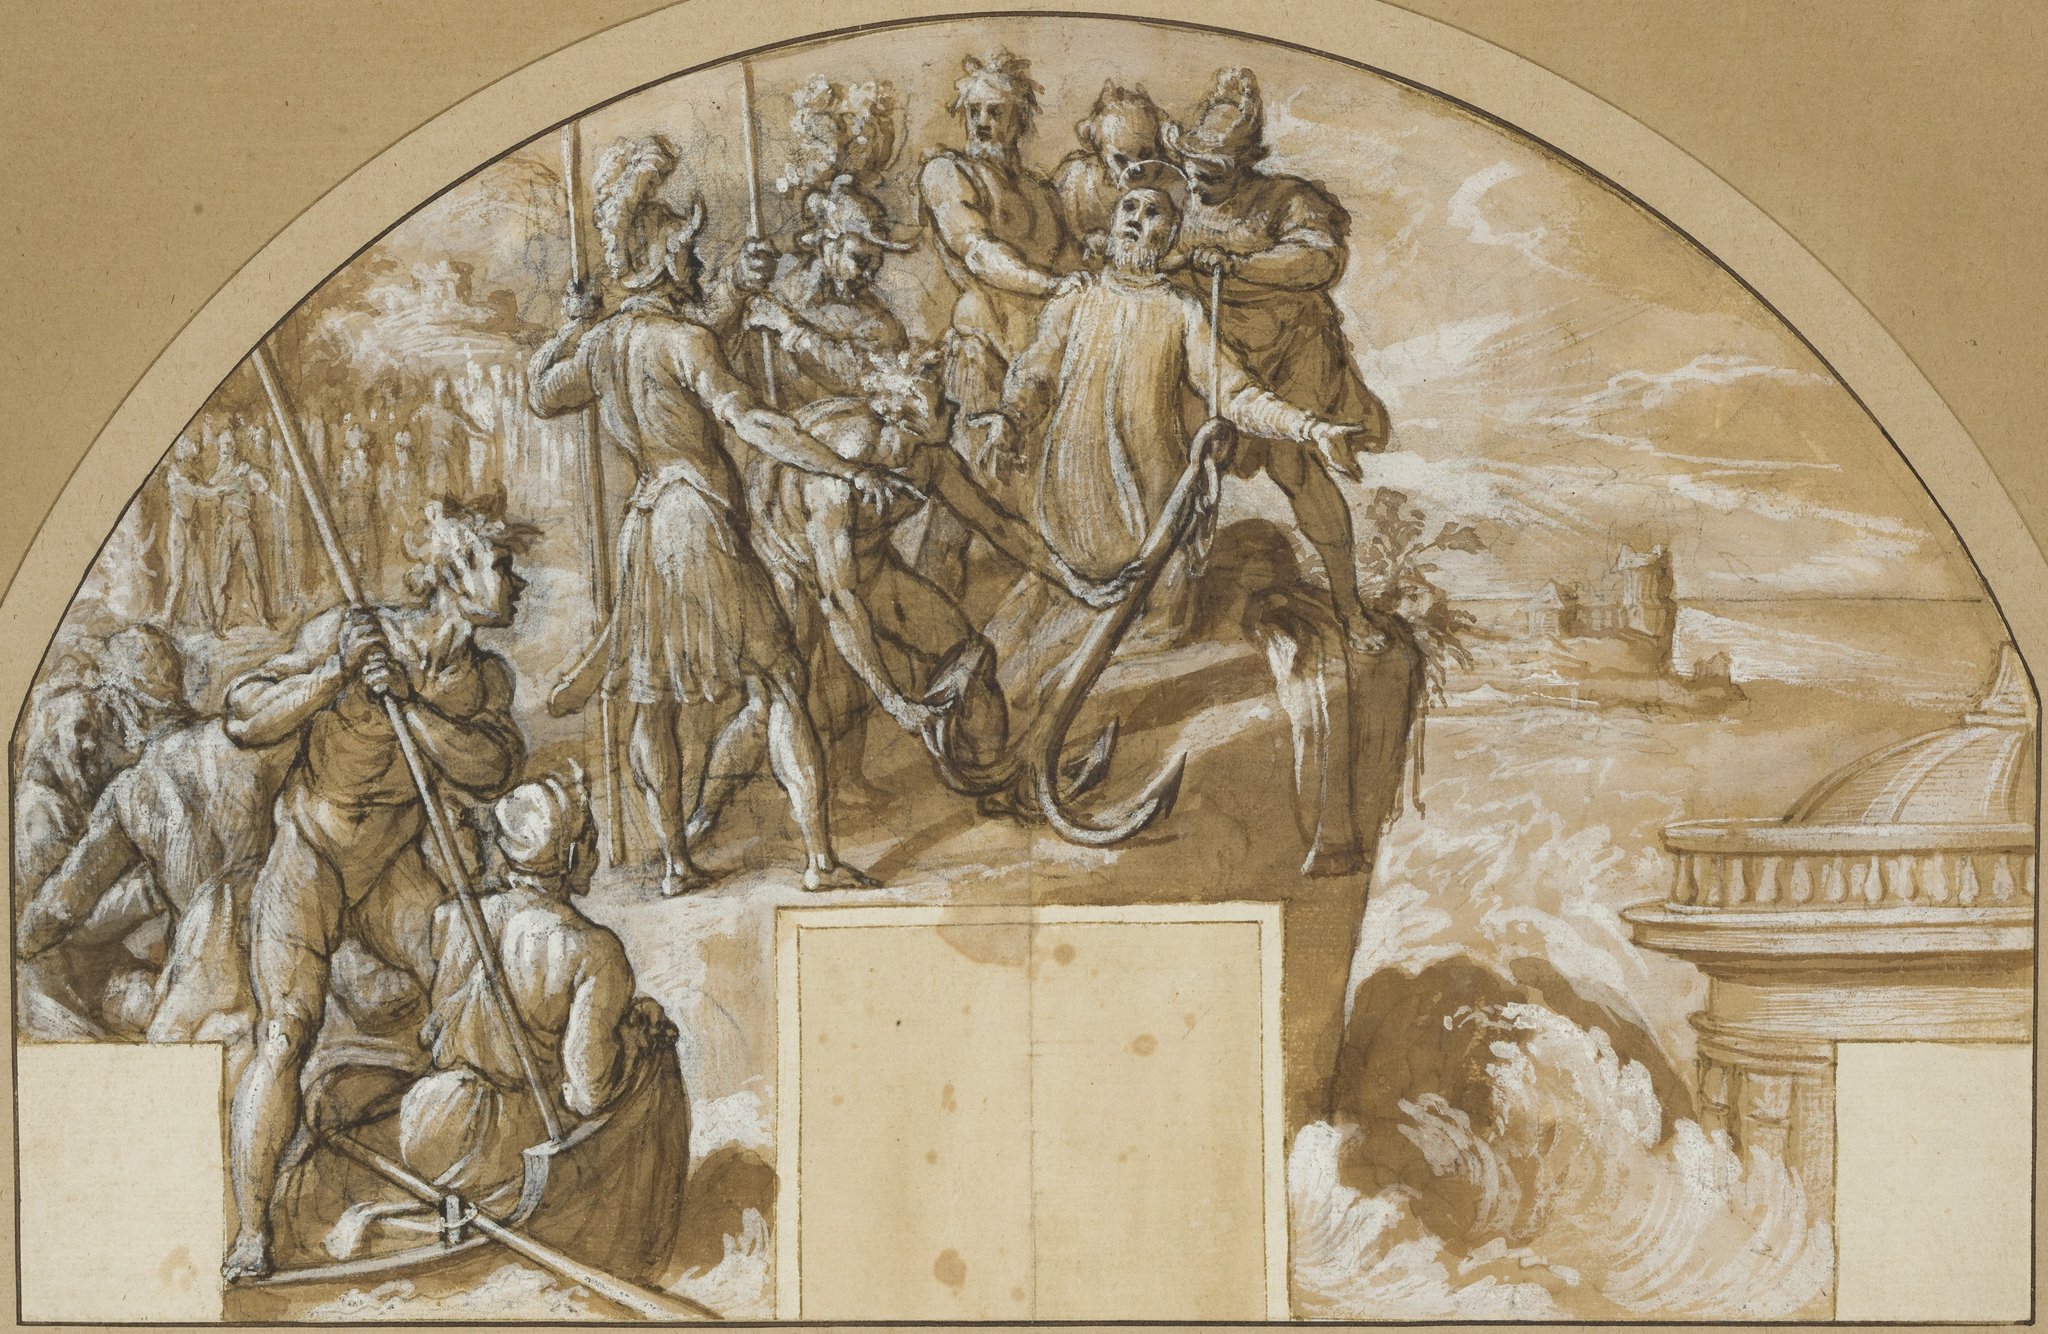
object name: drawing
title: The Martyrdom of Saint Clement I, Pope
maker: agostino ciampelli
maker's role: artist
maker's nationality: italian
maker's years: 1565-1630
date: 1596-1597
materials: chalk, ink, paper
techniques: brush, highlighting, pen, wash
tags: popes,saints,boats